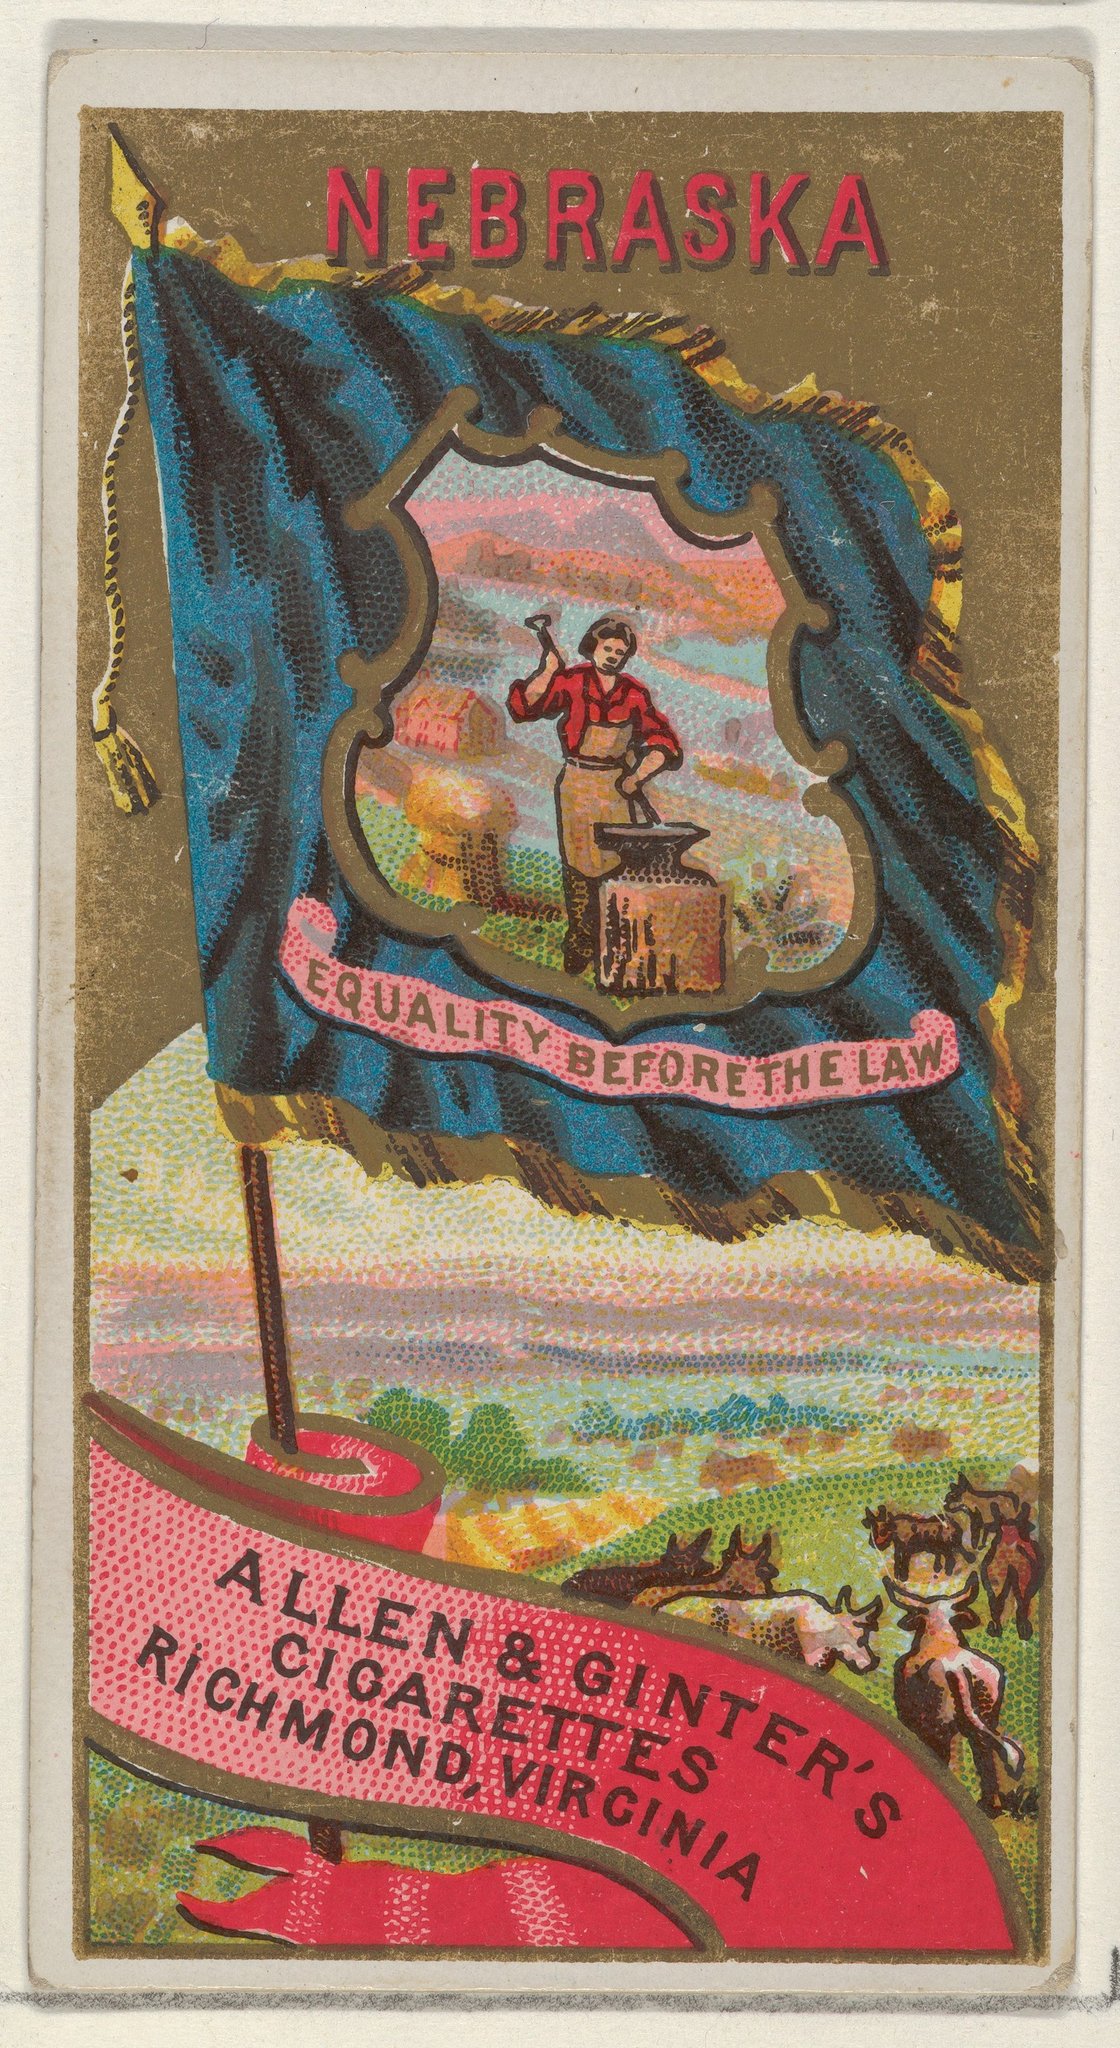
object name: print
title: Nebraska, from Flags of the States and Territories (N11) for Allen & Ginter Cigarettes Brands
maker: allen & ginter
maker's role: publisher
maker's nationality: american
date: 1888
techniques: color lithograph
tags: men,cows,working,flags